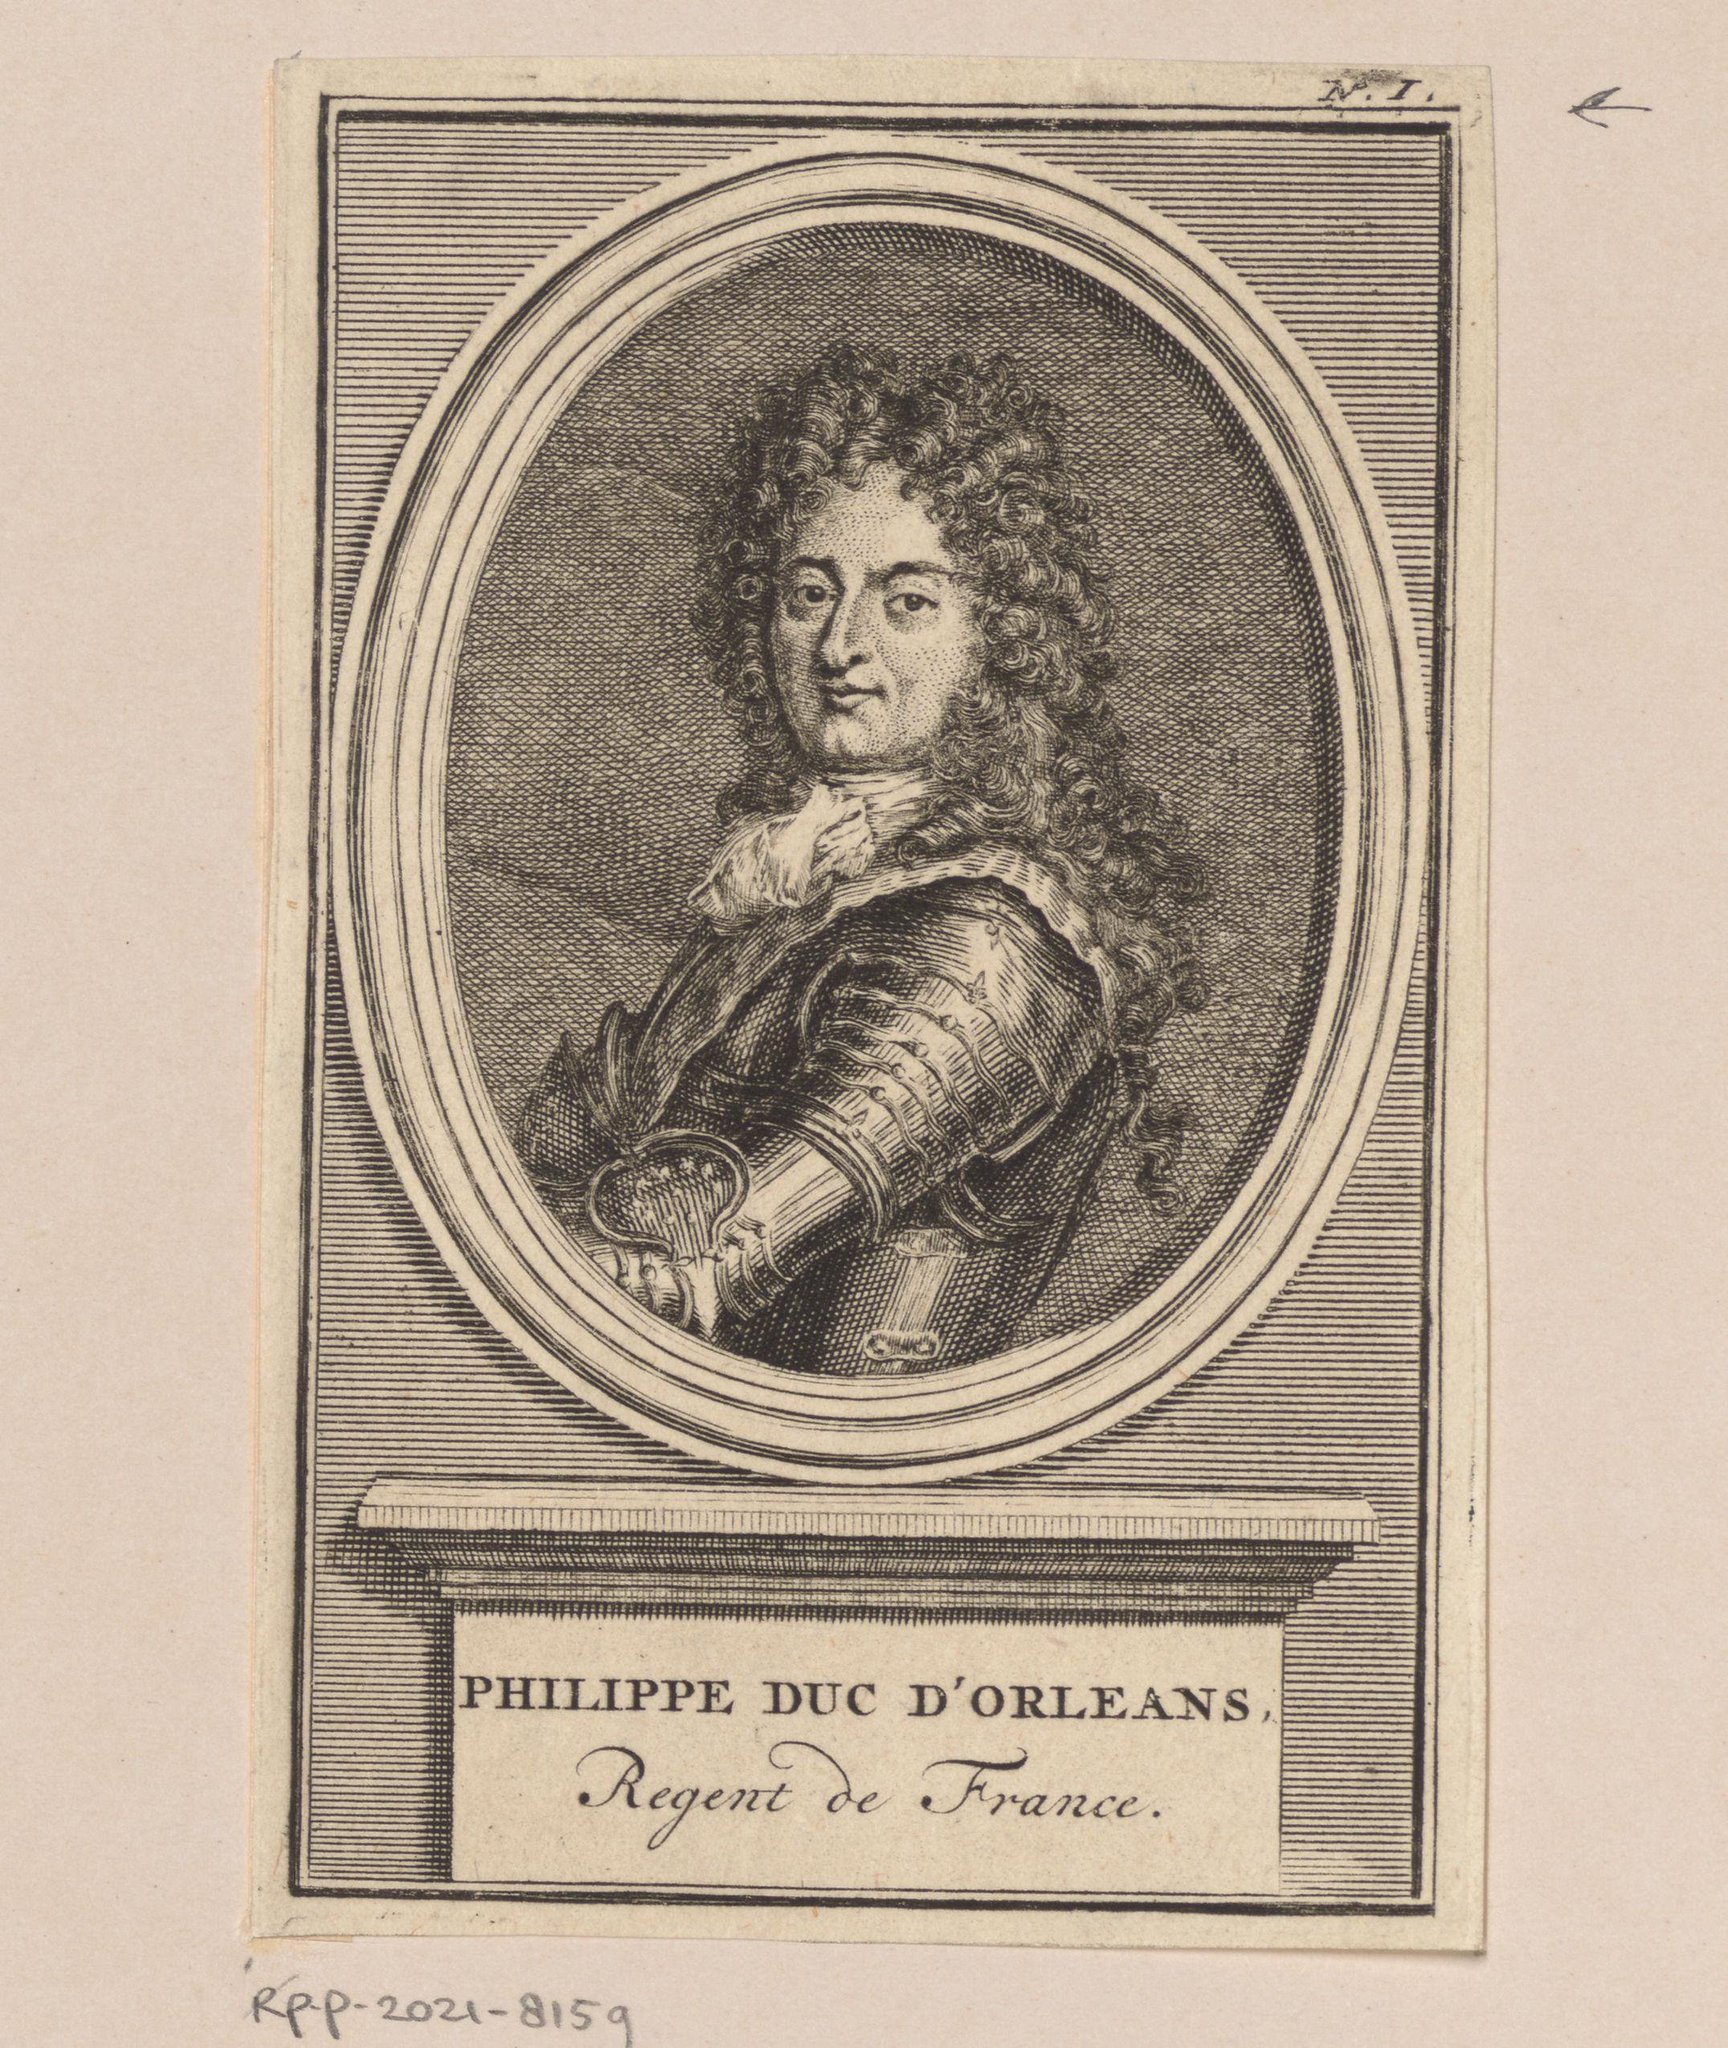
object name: print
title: Portret van Filips II, hertog van Orléans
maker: Anonymous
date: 1700-1749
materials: paper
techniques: engraving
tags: filips ii (hertog van orléans), armour, adult man, historical persons